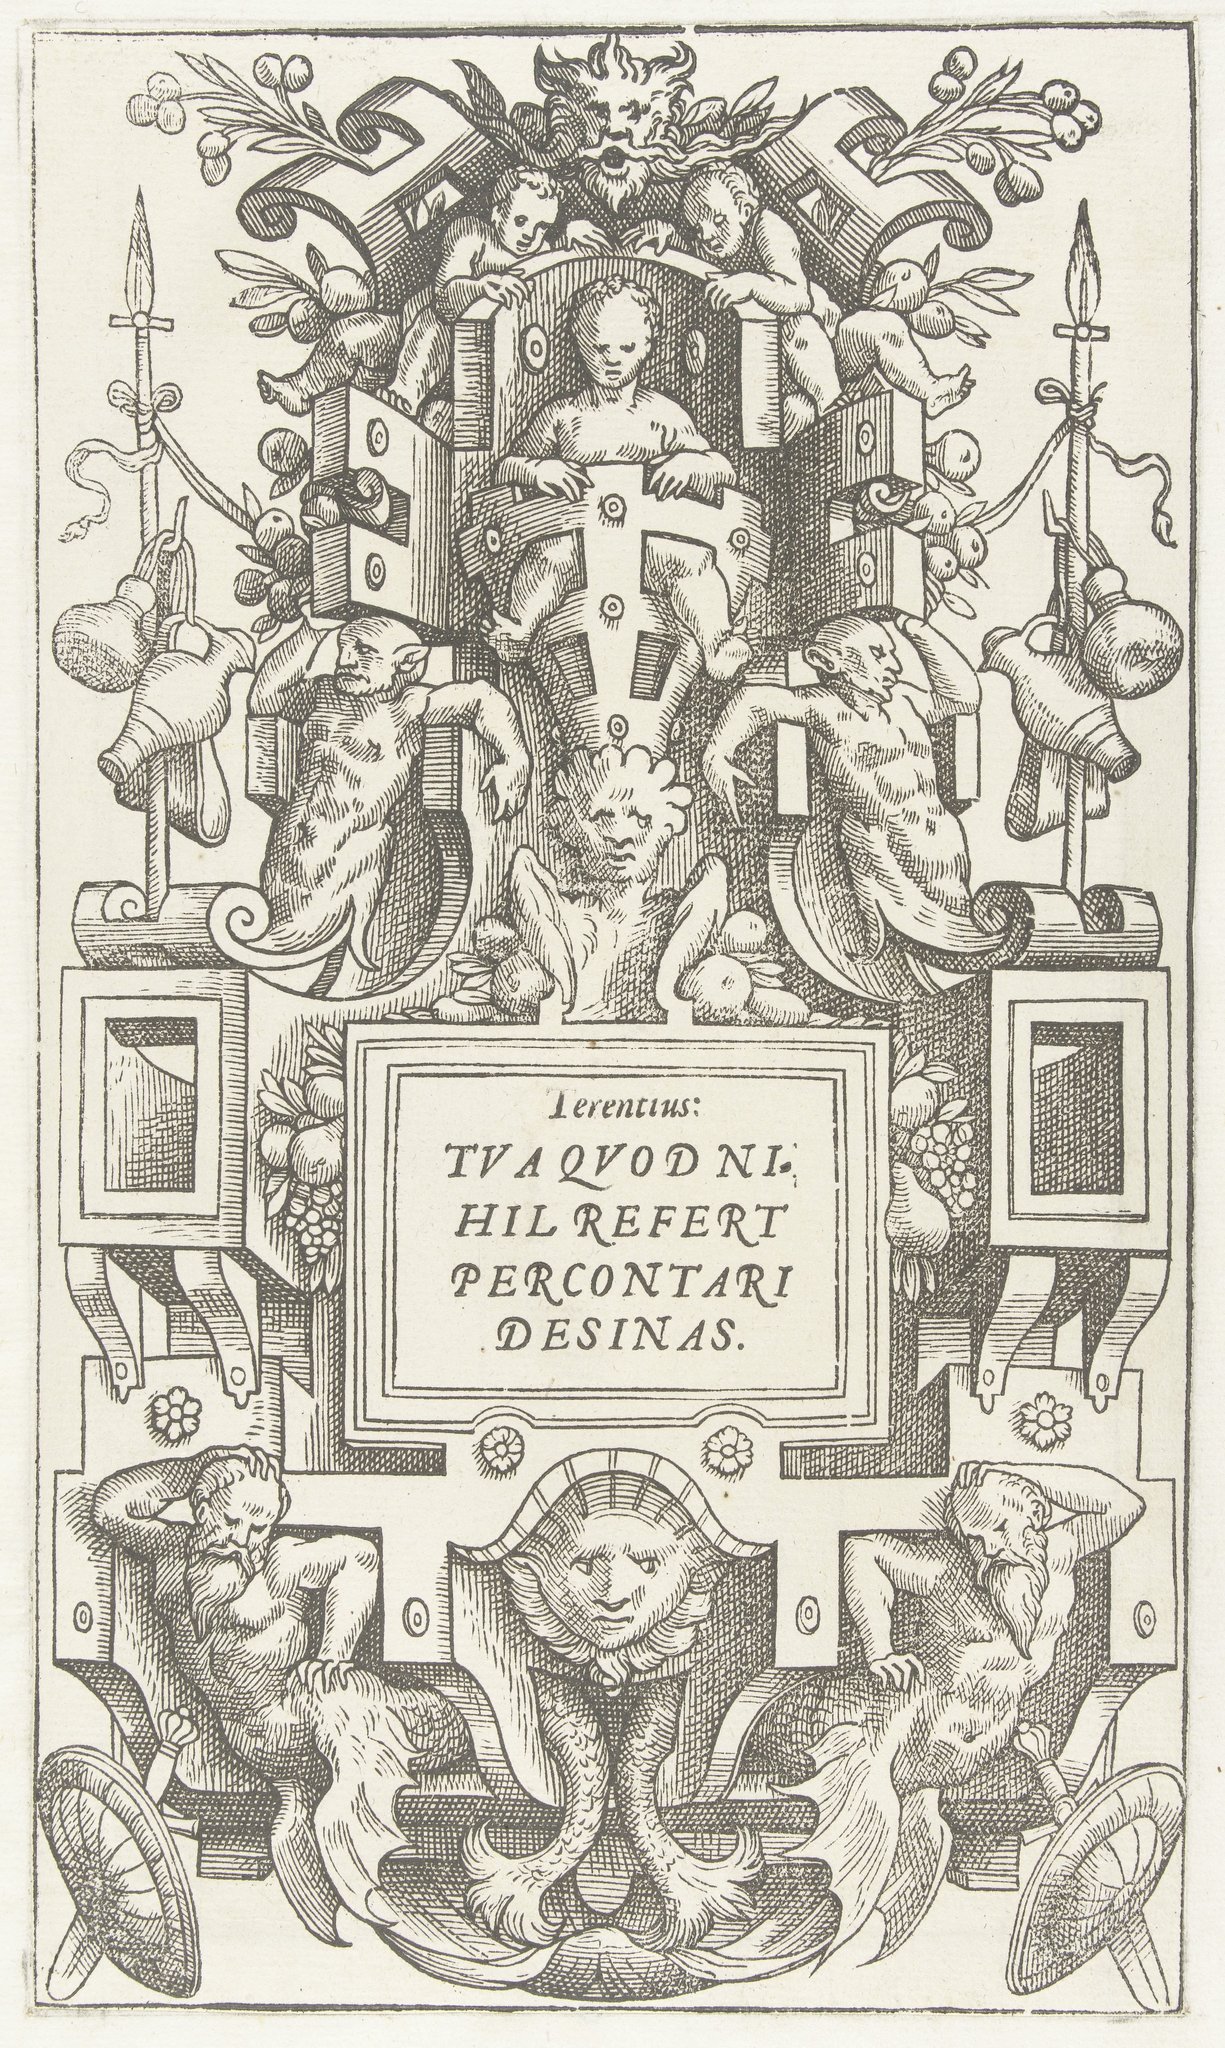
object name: print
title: Cartouche met een citaat van Terentius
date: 1556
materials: paper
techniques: woodcut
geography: netherlands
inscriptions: number: ‘48’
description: Onderaan hangen in het rolwerk twee tritons. Op de cartouche staat een nis van rolwerk, ondersteund door twee kale hermen. Blad hoort bij 15 bladen met titelblad afkomstig uit een serie van 24 bladen. Houtsneden.